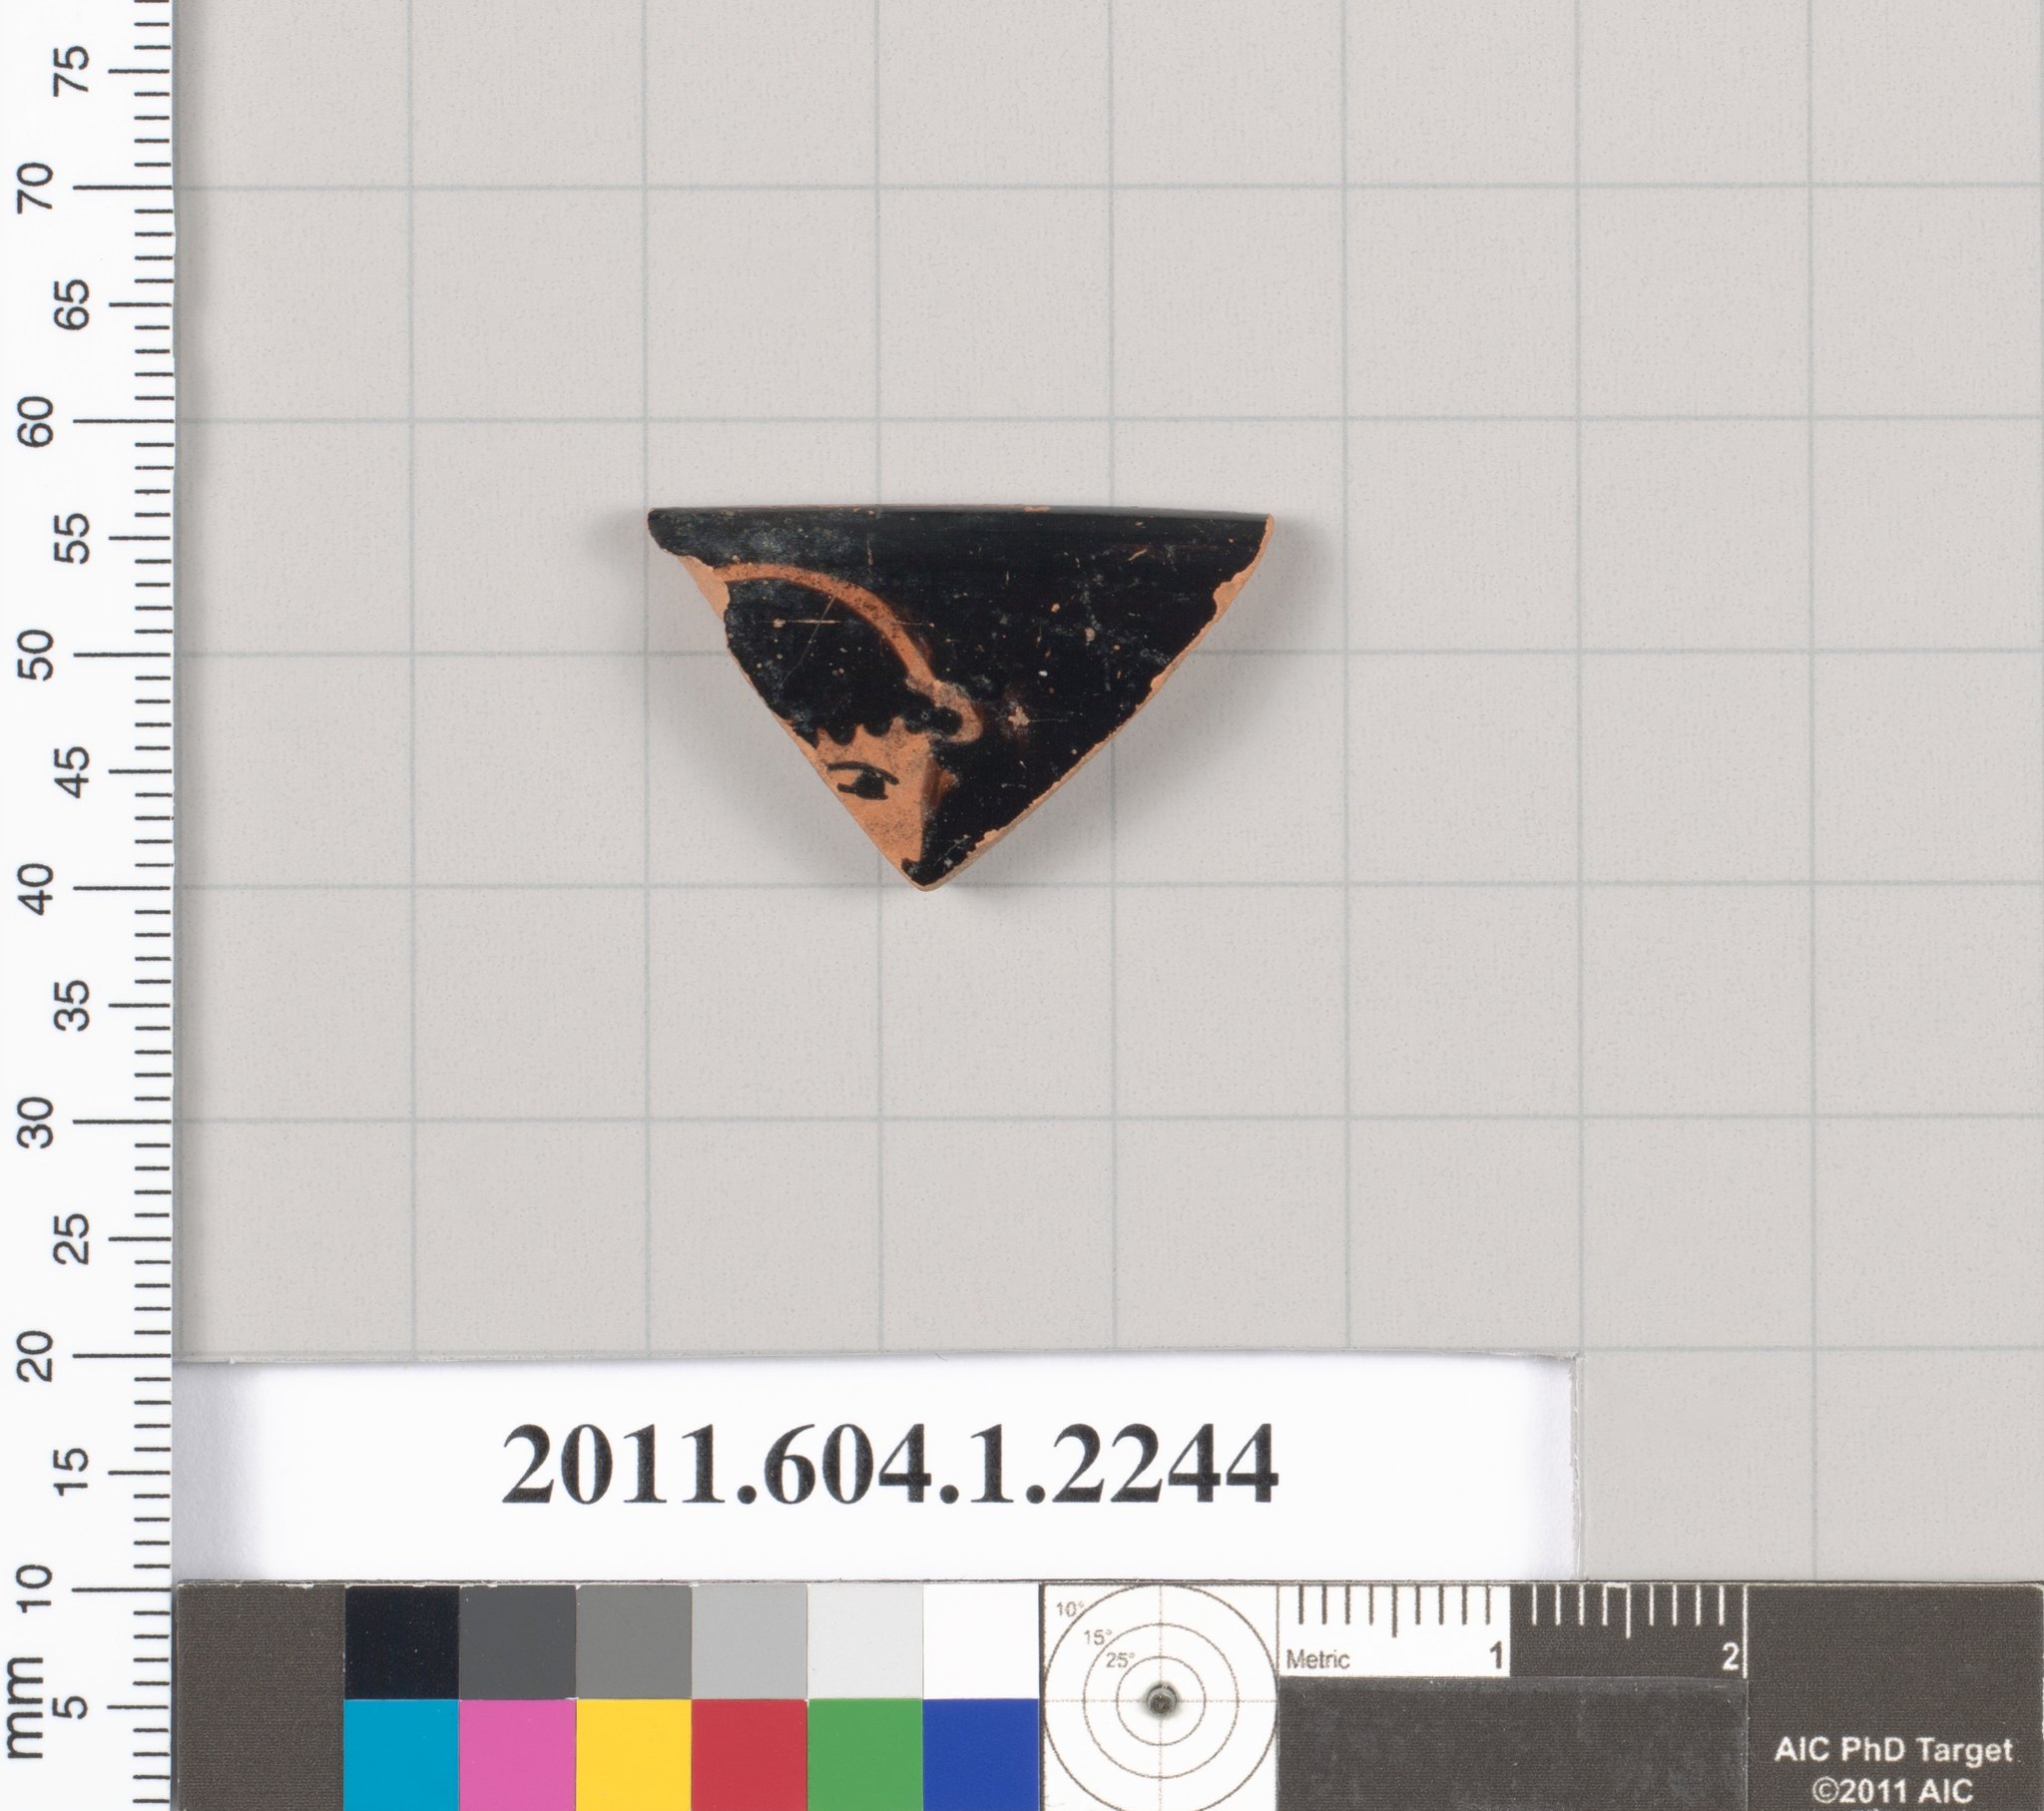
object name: kylix fragment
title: Terracotta rim fragment of a kylix (drinking cup)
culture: greek, attic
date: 475-451 BCE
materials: terracotta